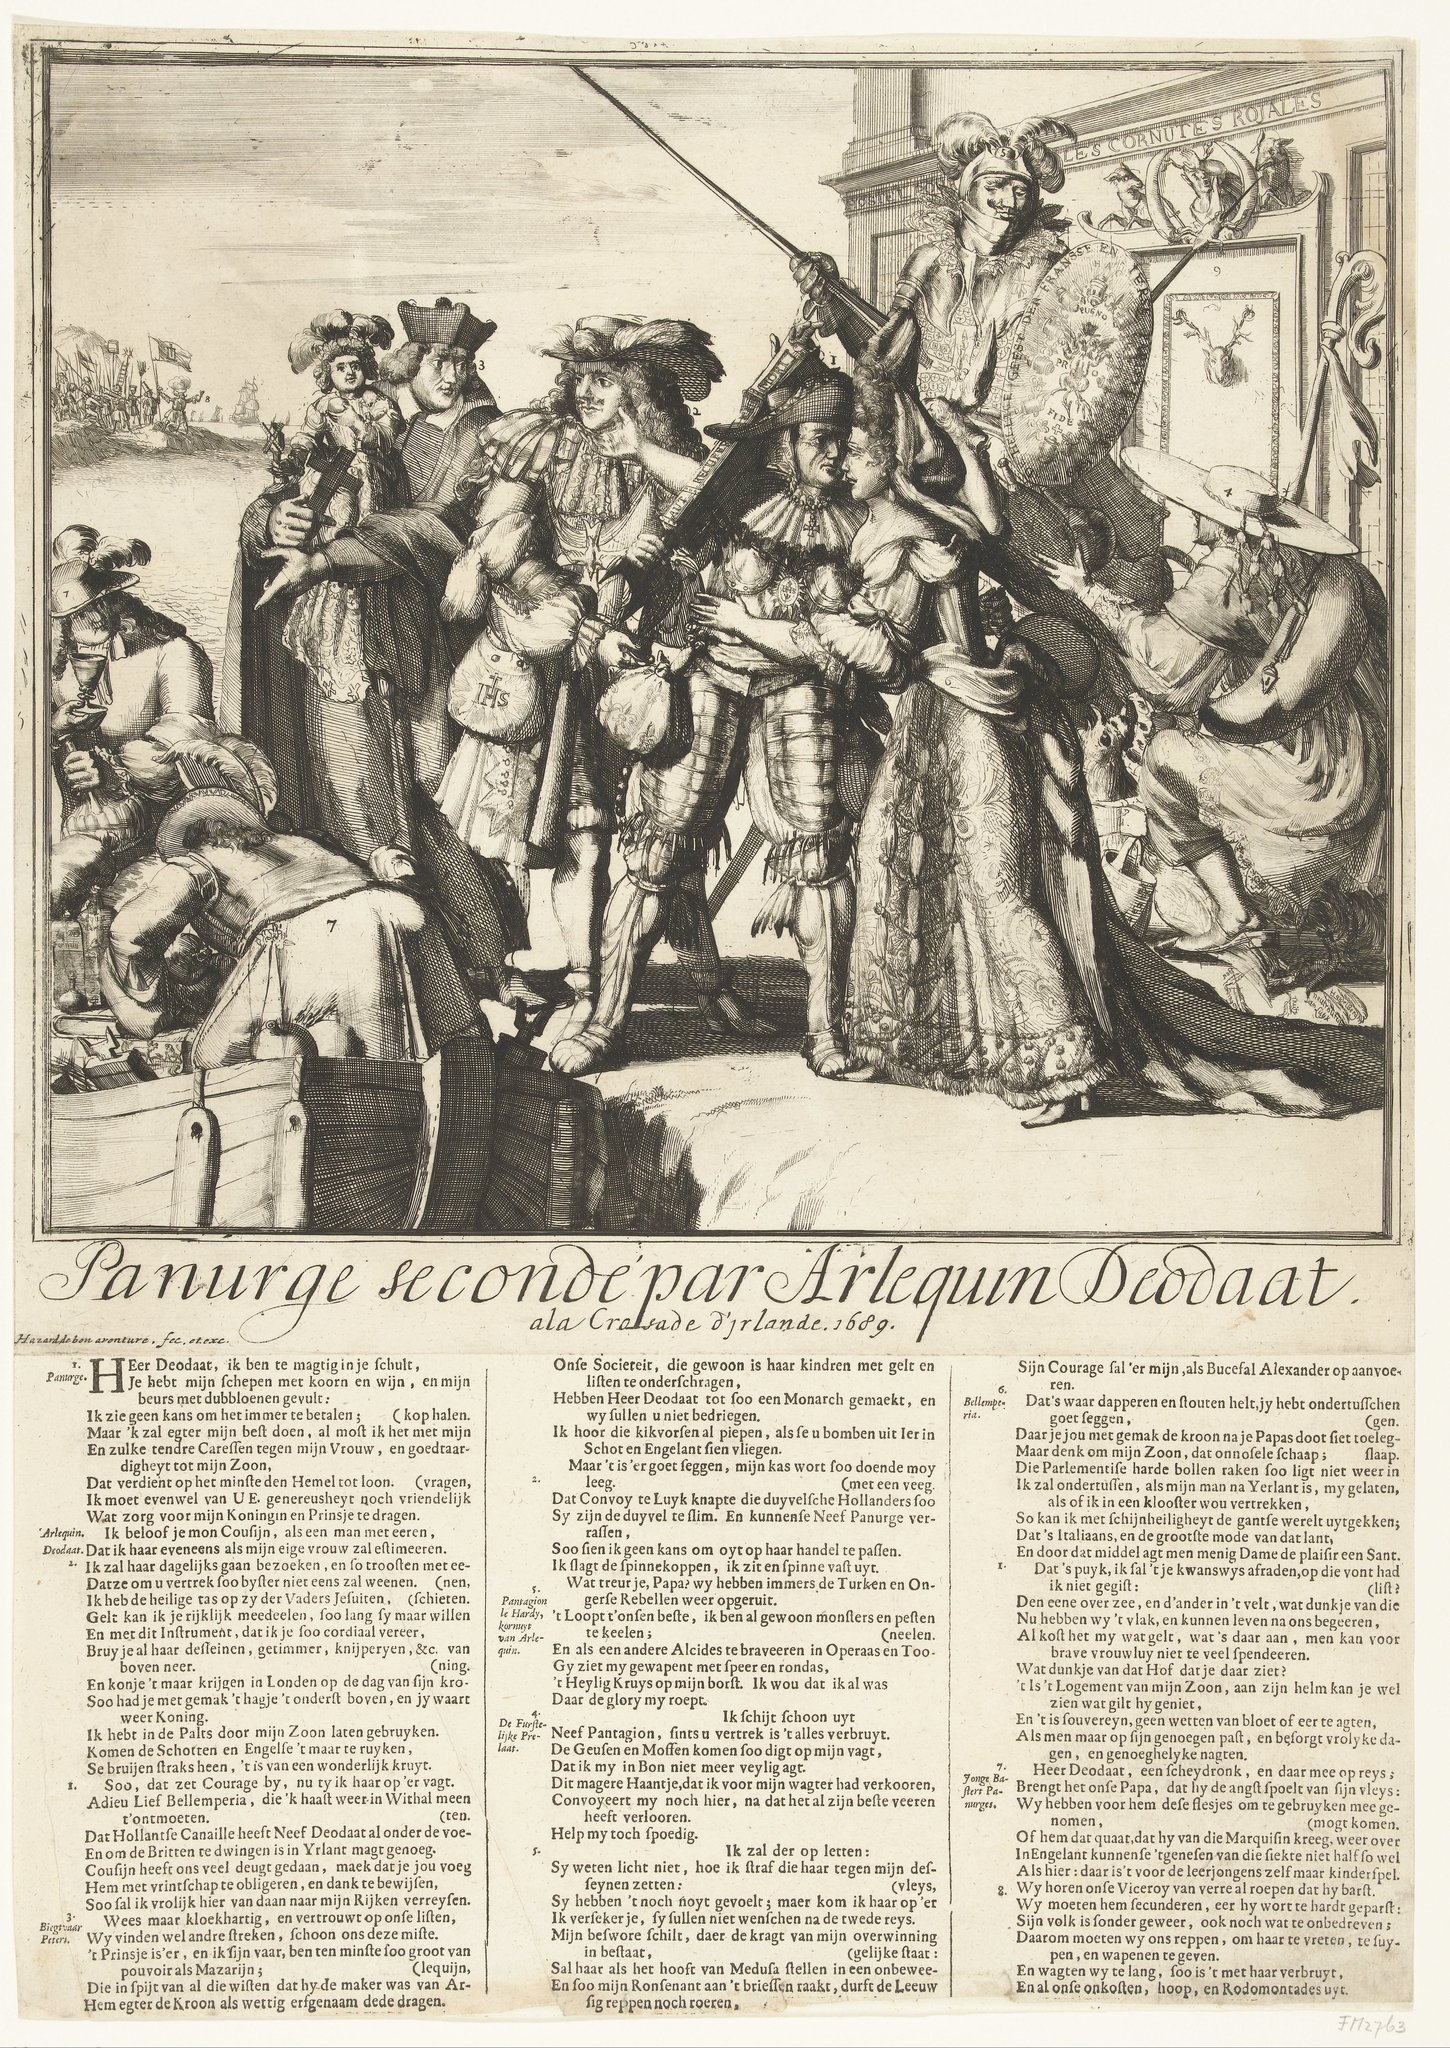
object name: print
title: Panurge secondé par Arlequin Deodat ala Crosade d'irlande. 1689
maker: romeyn de hooghe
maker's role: draughtsman, goldsmith, painter, print maker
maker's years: 1645-1708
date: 1689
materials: paper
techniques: engraving, etching, letterpress printing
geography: northern netherlands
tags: jacobus ii (koning van engeland en schotland), lodewijk xiv (koning van frankrijk), paris, dauphin van frankrijk lodewijk, london, rome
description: Spotprent op het vertrek van Jacobus II naar Ierland, maart 1689. Jacobus neemt afscheid van zijn vrouw Maria van Modena die onderwijl Lodewijk XIV liefkoost. De Franse koning geeft Jacobus een zak met geld, links pater Peters (Edward Petre) met het ondergeschoven kind op de arm. Rechts beklaagt de kardinaal en bisschop van Straatsburg zich tegenover de dauphin die op een ezel zit. Linksvoor wordt een bootje in gereedheid gebracht voor vertrek. Onder de voorstelling een vers in 3 kolommen met een verklaring van de cijfers 1-8 in het Nederlands.